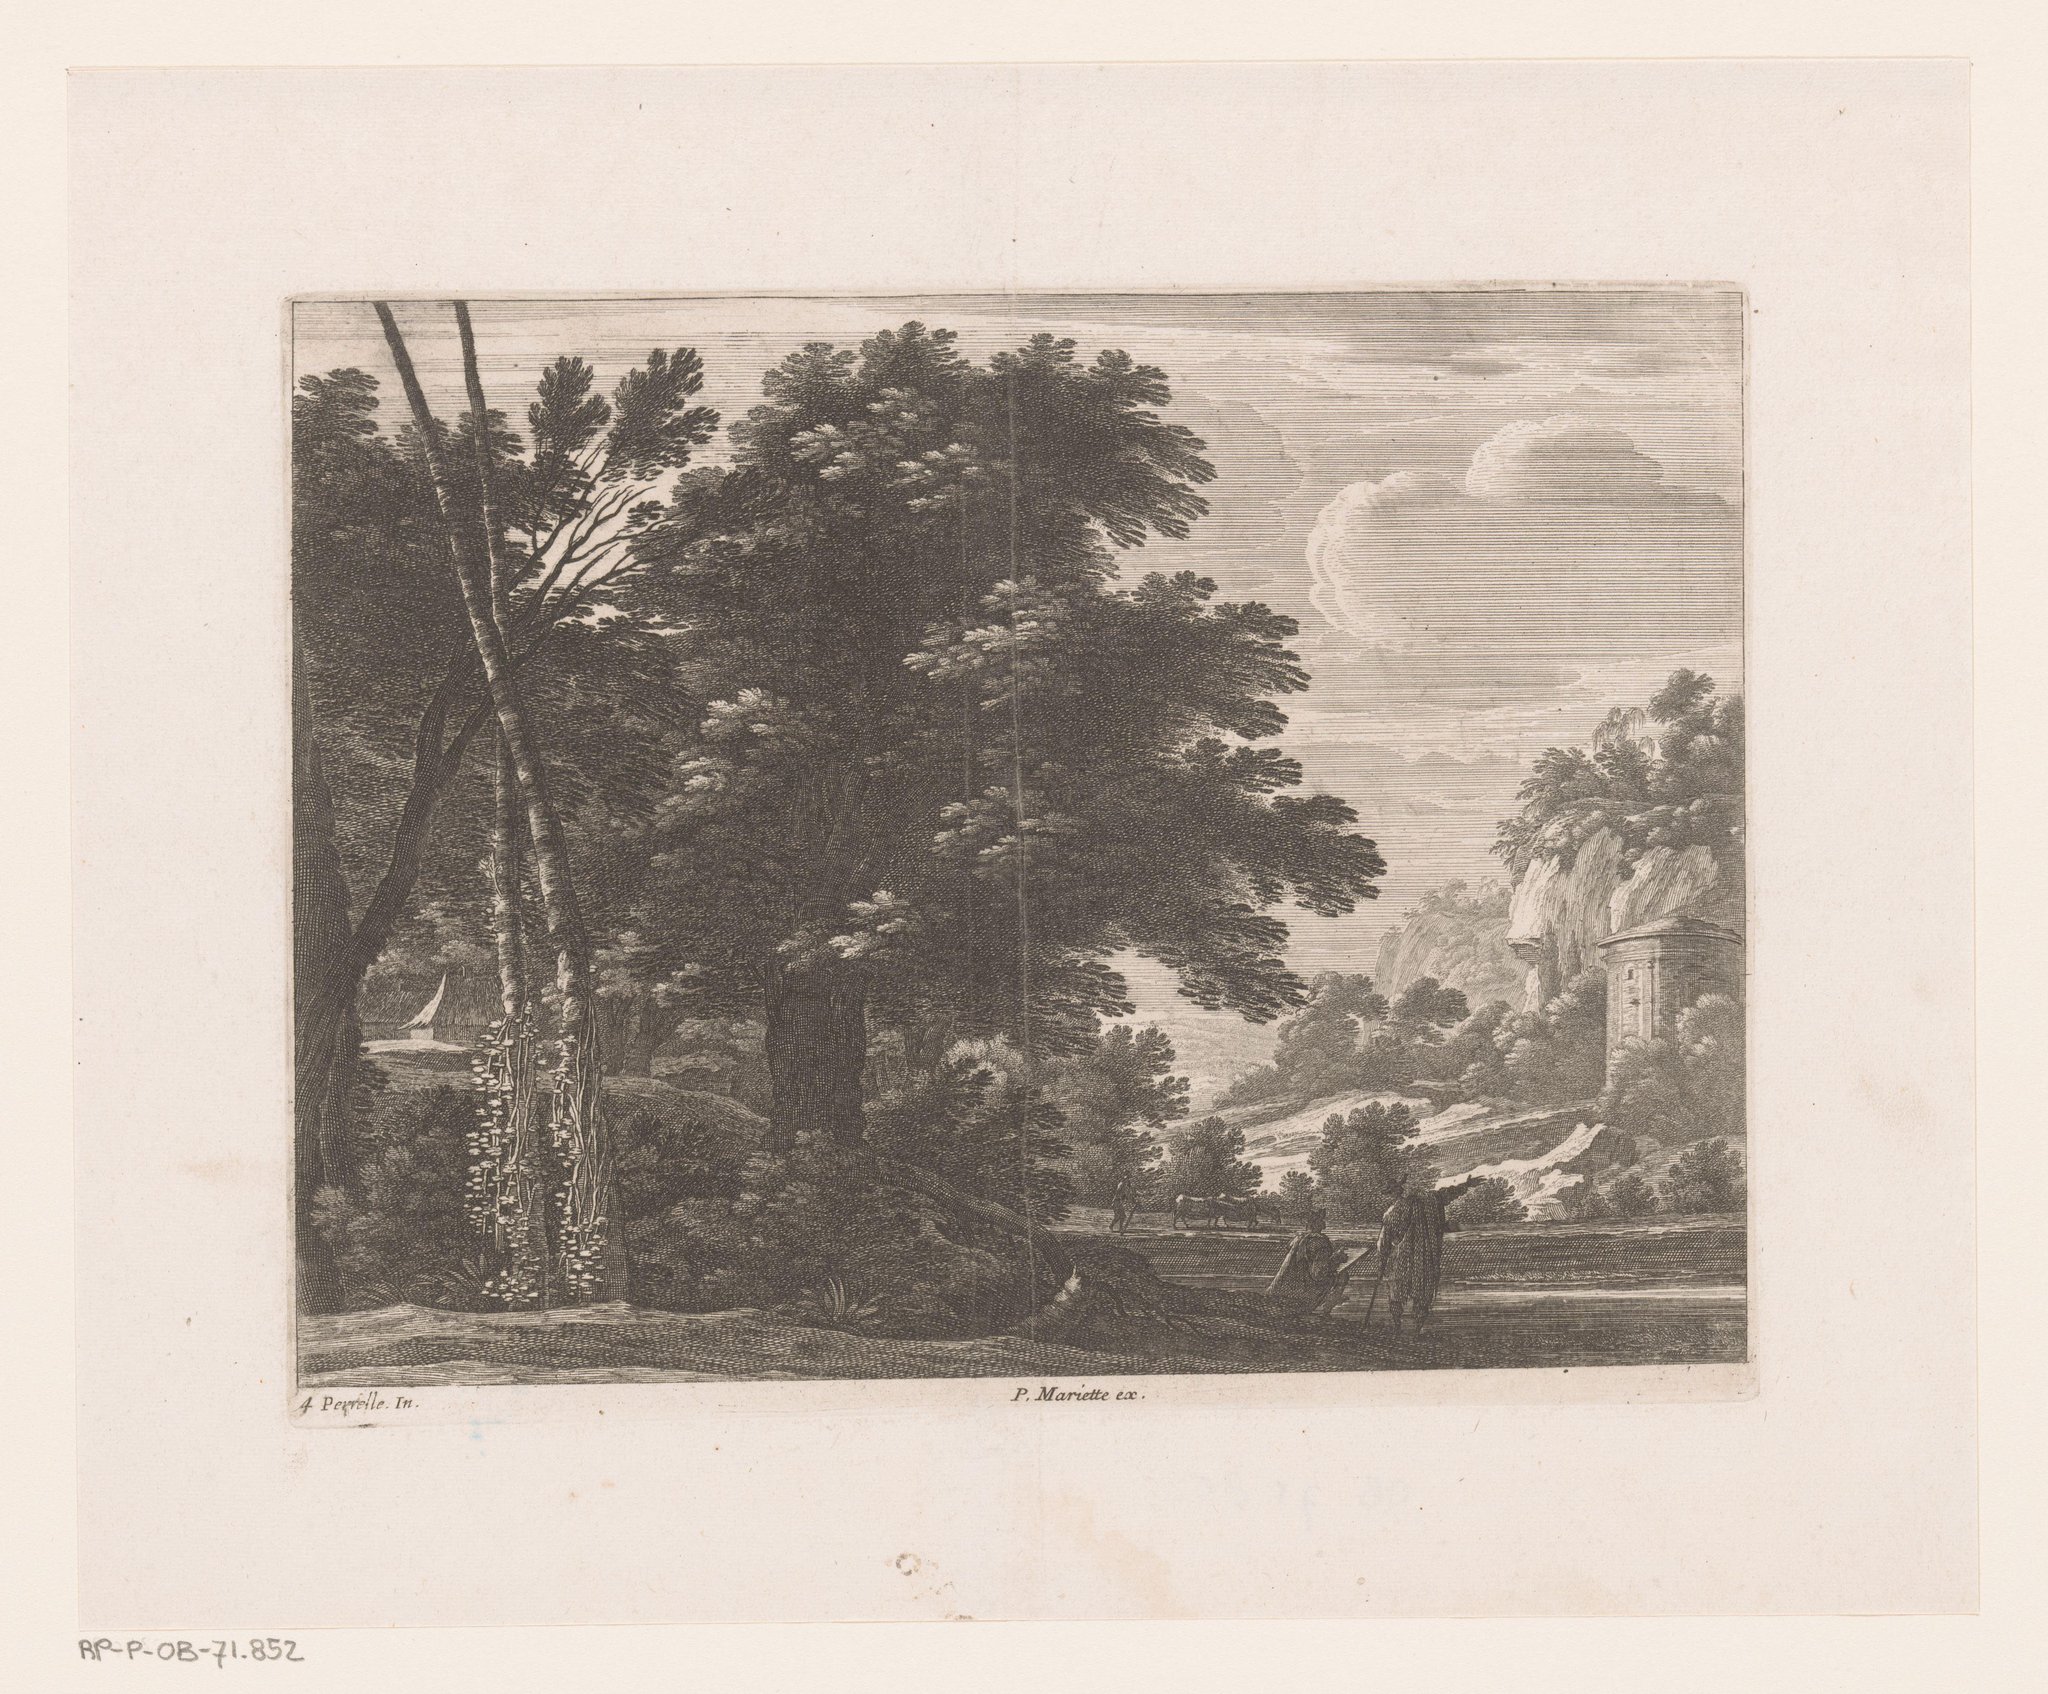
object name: print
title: Tekenende en staande man aan de rand van het bos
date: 1613-1695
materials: paper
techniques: engraving, etching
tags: fringe, edge of the wood, artist at work, in his workshop - bb - out of doors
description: Prenten met het signatuur 'Perelle' kunnen zowel door vader Gabriel als door zonen Nicolas en Adam gemaakt zijn.